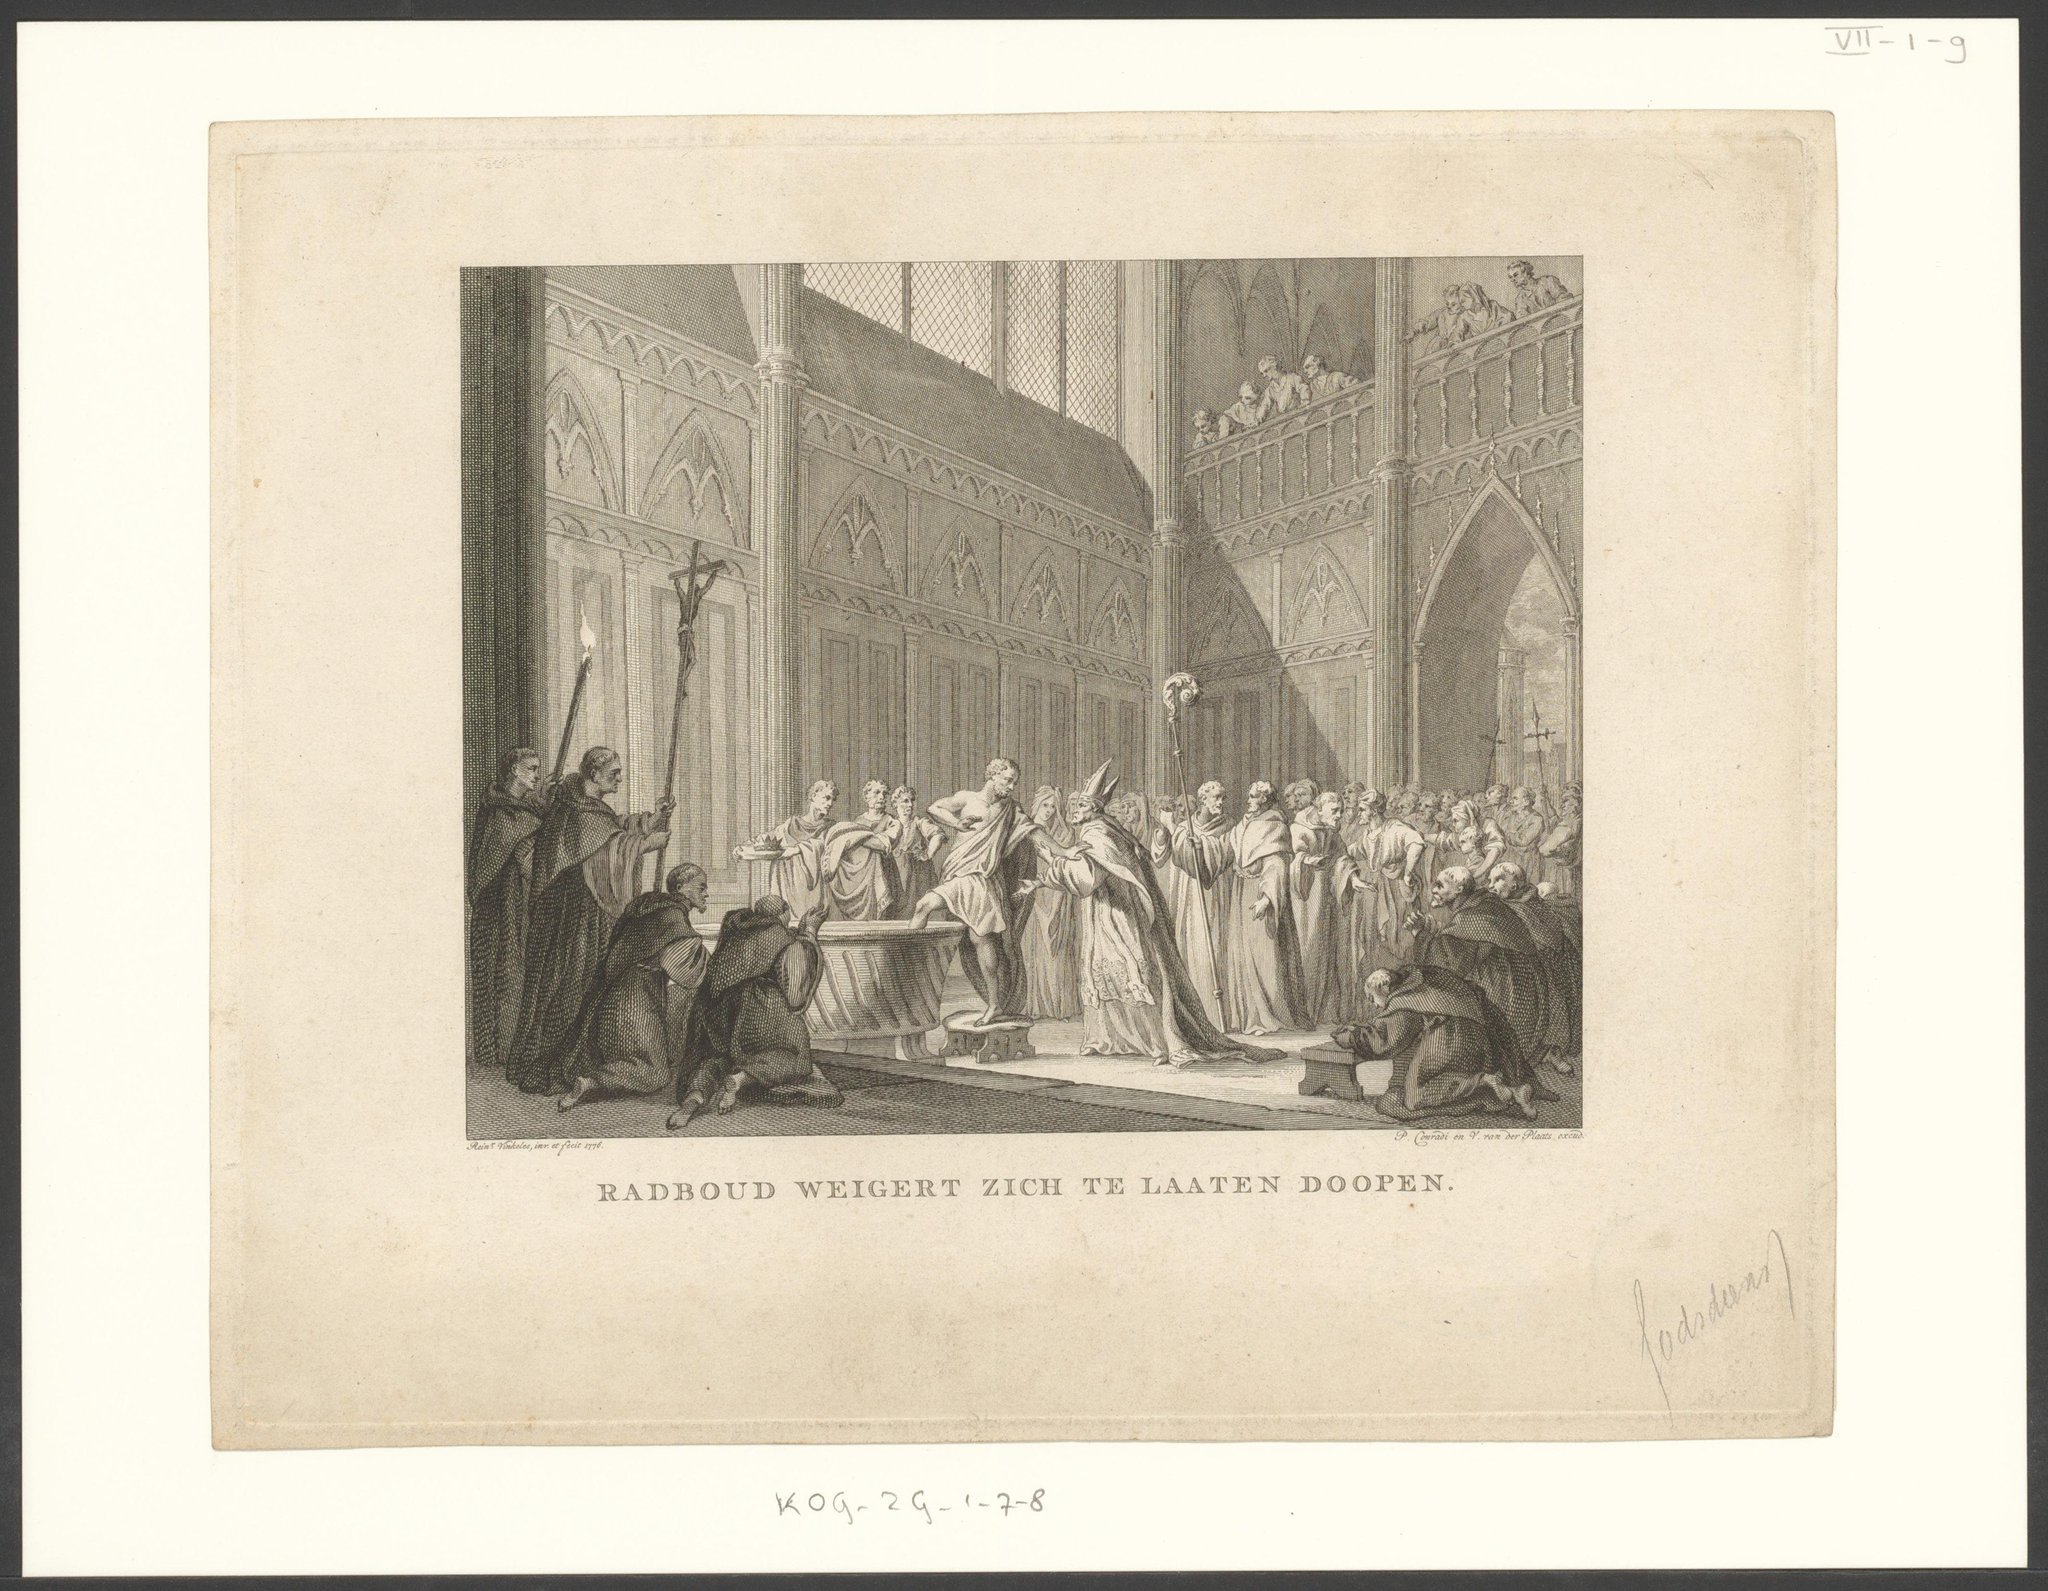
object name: print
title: Radboud, zesde koning der Friezen, weigert zich te laten dopen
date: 1776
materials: paper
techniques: engraving, etching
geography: amsterdam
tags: baptism, christening ceremony ~ the first of the seven sacraments, ruler, sovereign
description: Radboud, zesde koning der Friezen, weigert zich te laten dopen. Onderwerpsrubrieken binnen de Atlas Zeden en Gewoonten: Godsdienst, Ned. Hervormden, (Oudtijds Gereformeerden), Synode van Dordrecht.